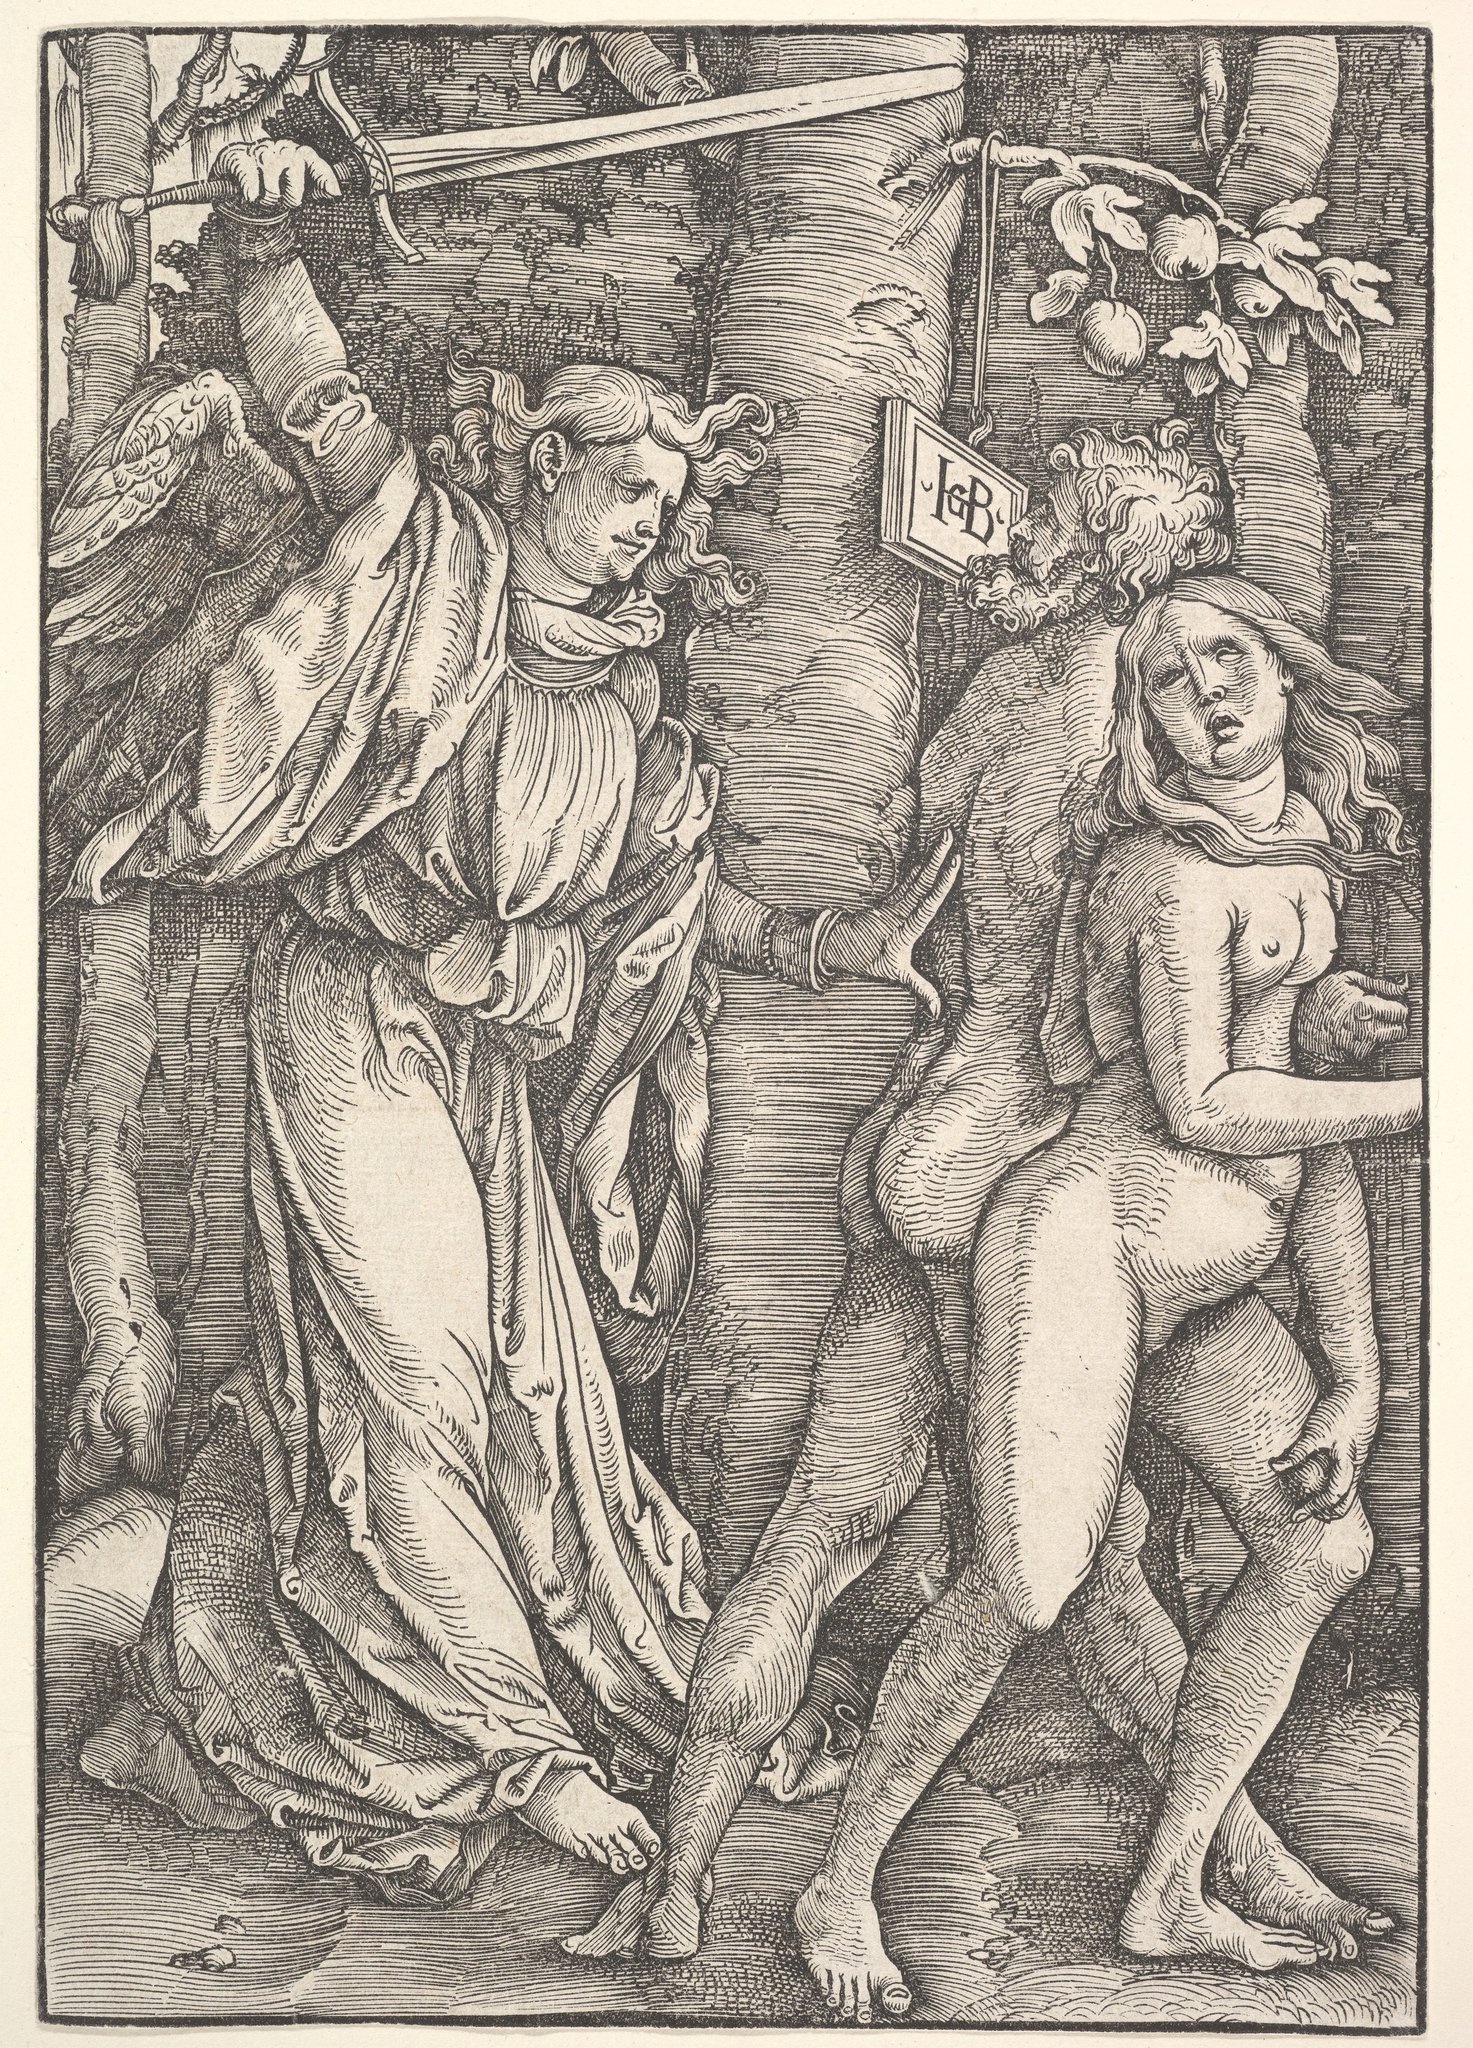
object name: print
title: Expulsion from Paradise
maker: hans baldung (called hans baldung grien)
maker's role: artist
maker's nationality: german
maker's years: 1484-1545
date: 1514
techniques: woodcut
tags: swords,men,female nudes,adam,eve